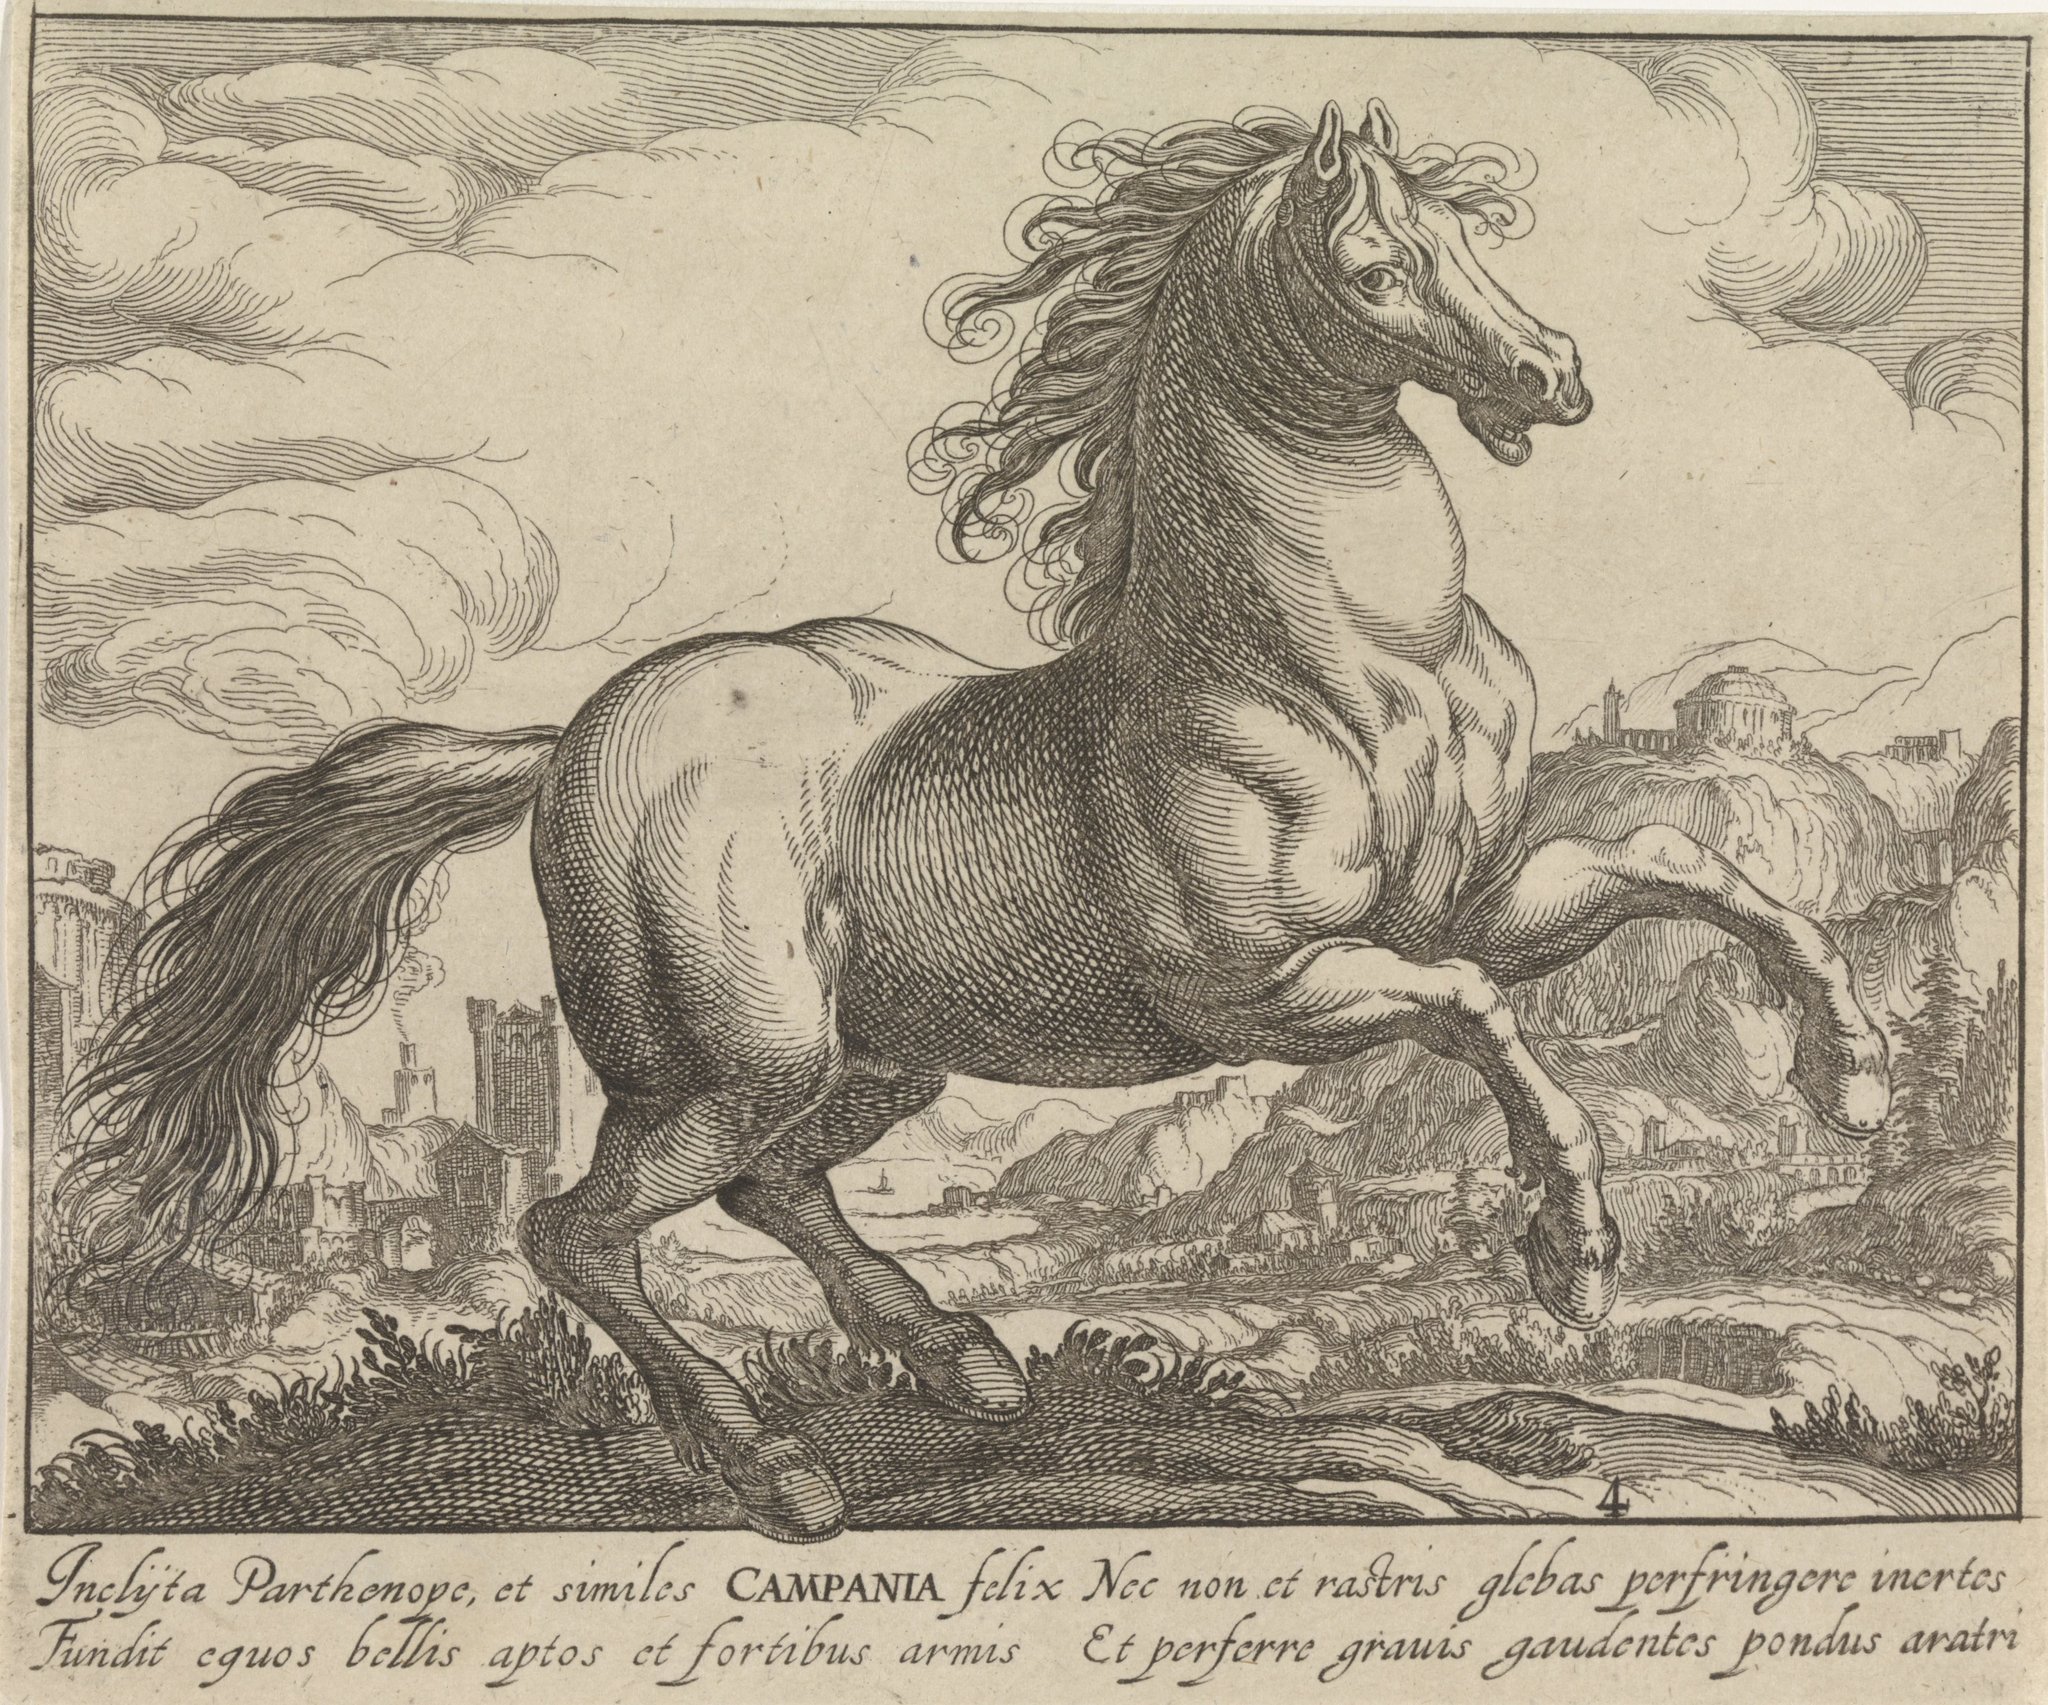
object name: print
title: Paardenrassen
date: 1590-1637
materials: paper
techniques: engraving, etching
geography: amsterdam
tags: horse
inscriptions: collector's mark: Lugt 2228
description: Heuvelachtig landschap met steigerend paard, naar rechts gewend. In de marge een tweeregelig onderschrift in het Latijn. Prent uit een serie van dertig met paardenrassen.